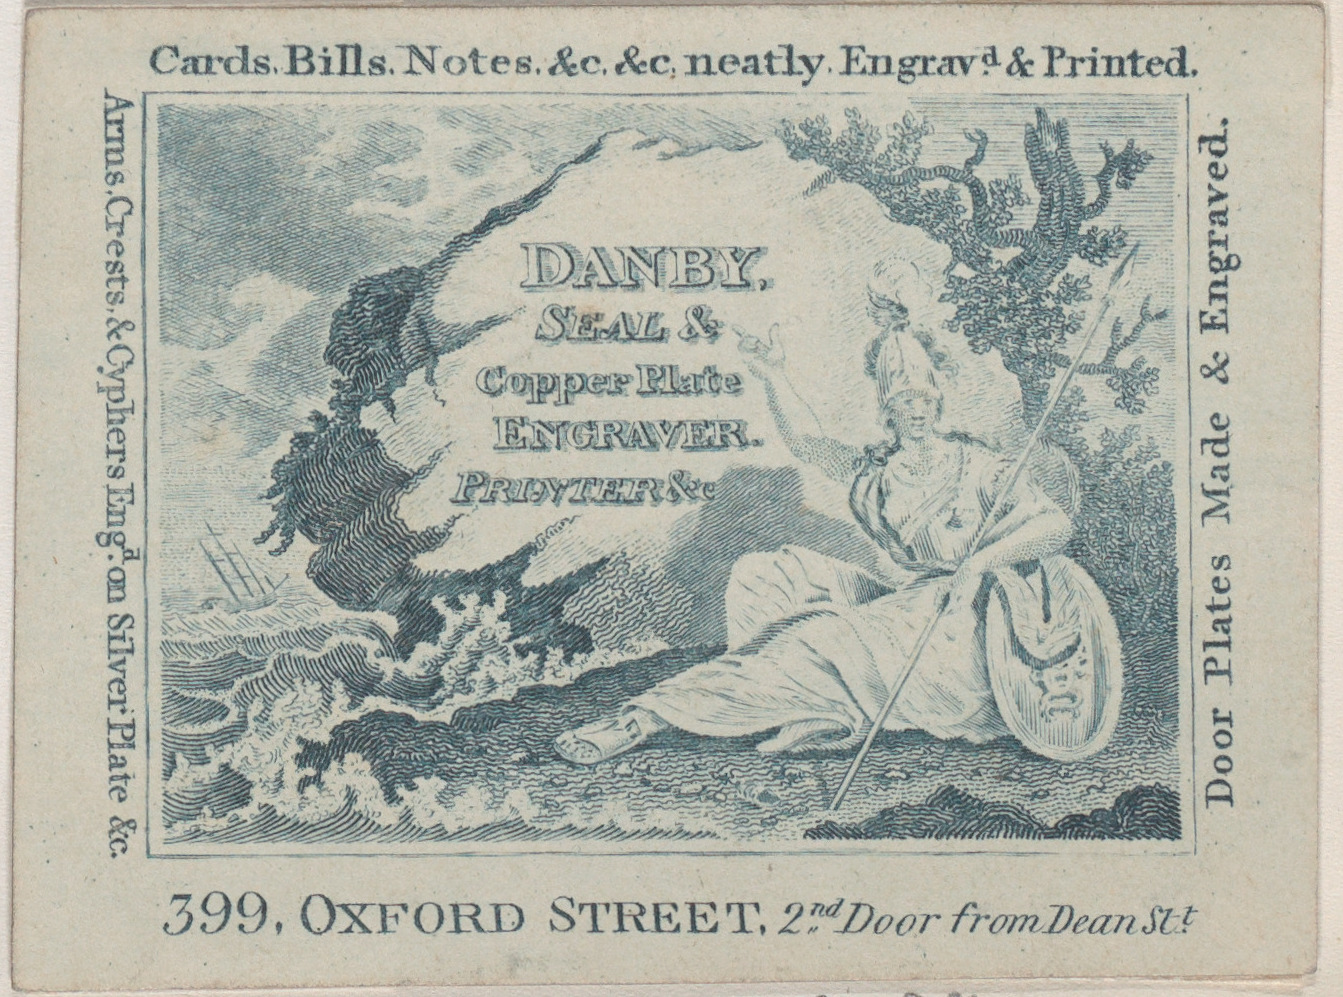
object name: print, trade card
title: Trade Card for Danby, Printer and Engraver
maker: anonymous, british, 19th century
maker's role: artist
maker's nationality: british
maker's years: 1800-1900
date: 1801-1900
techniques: engraving